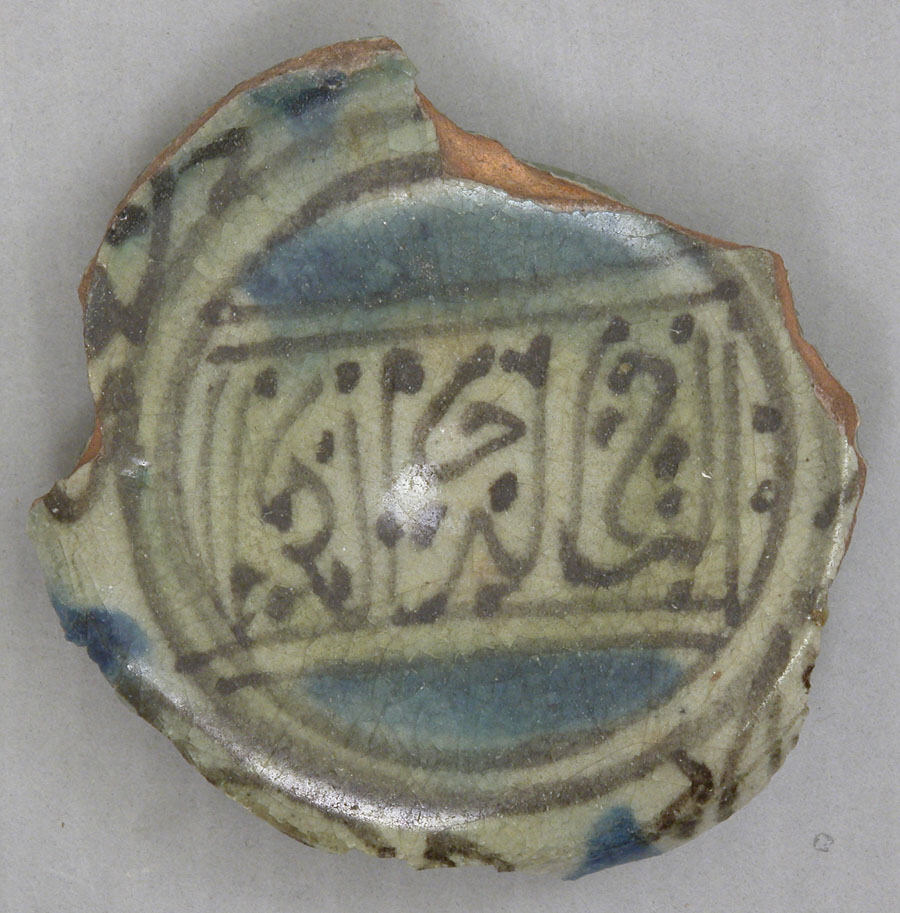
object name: fragment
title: Fragment of a Bowl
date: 1301-1500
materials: stonepaste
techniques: painting, polychrome, underglaze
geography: egypt